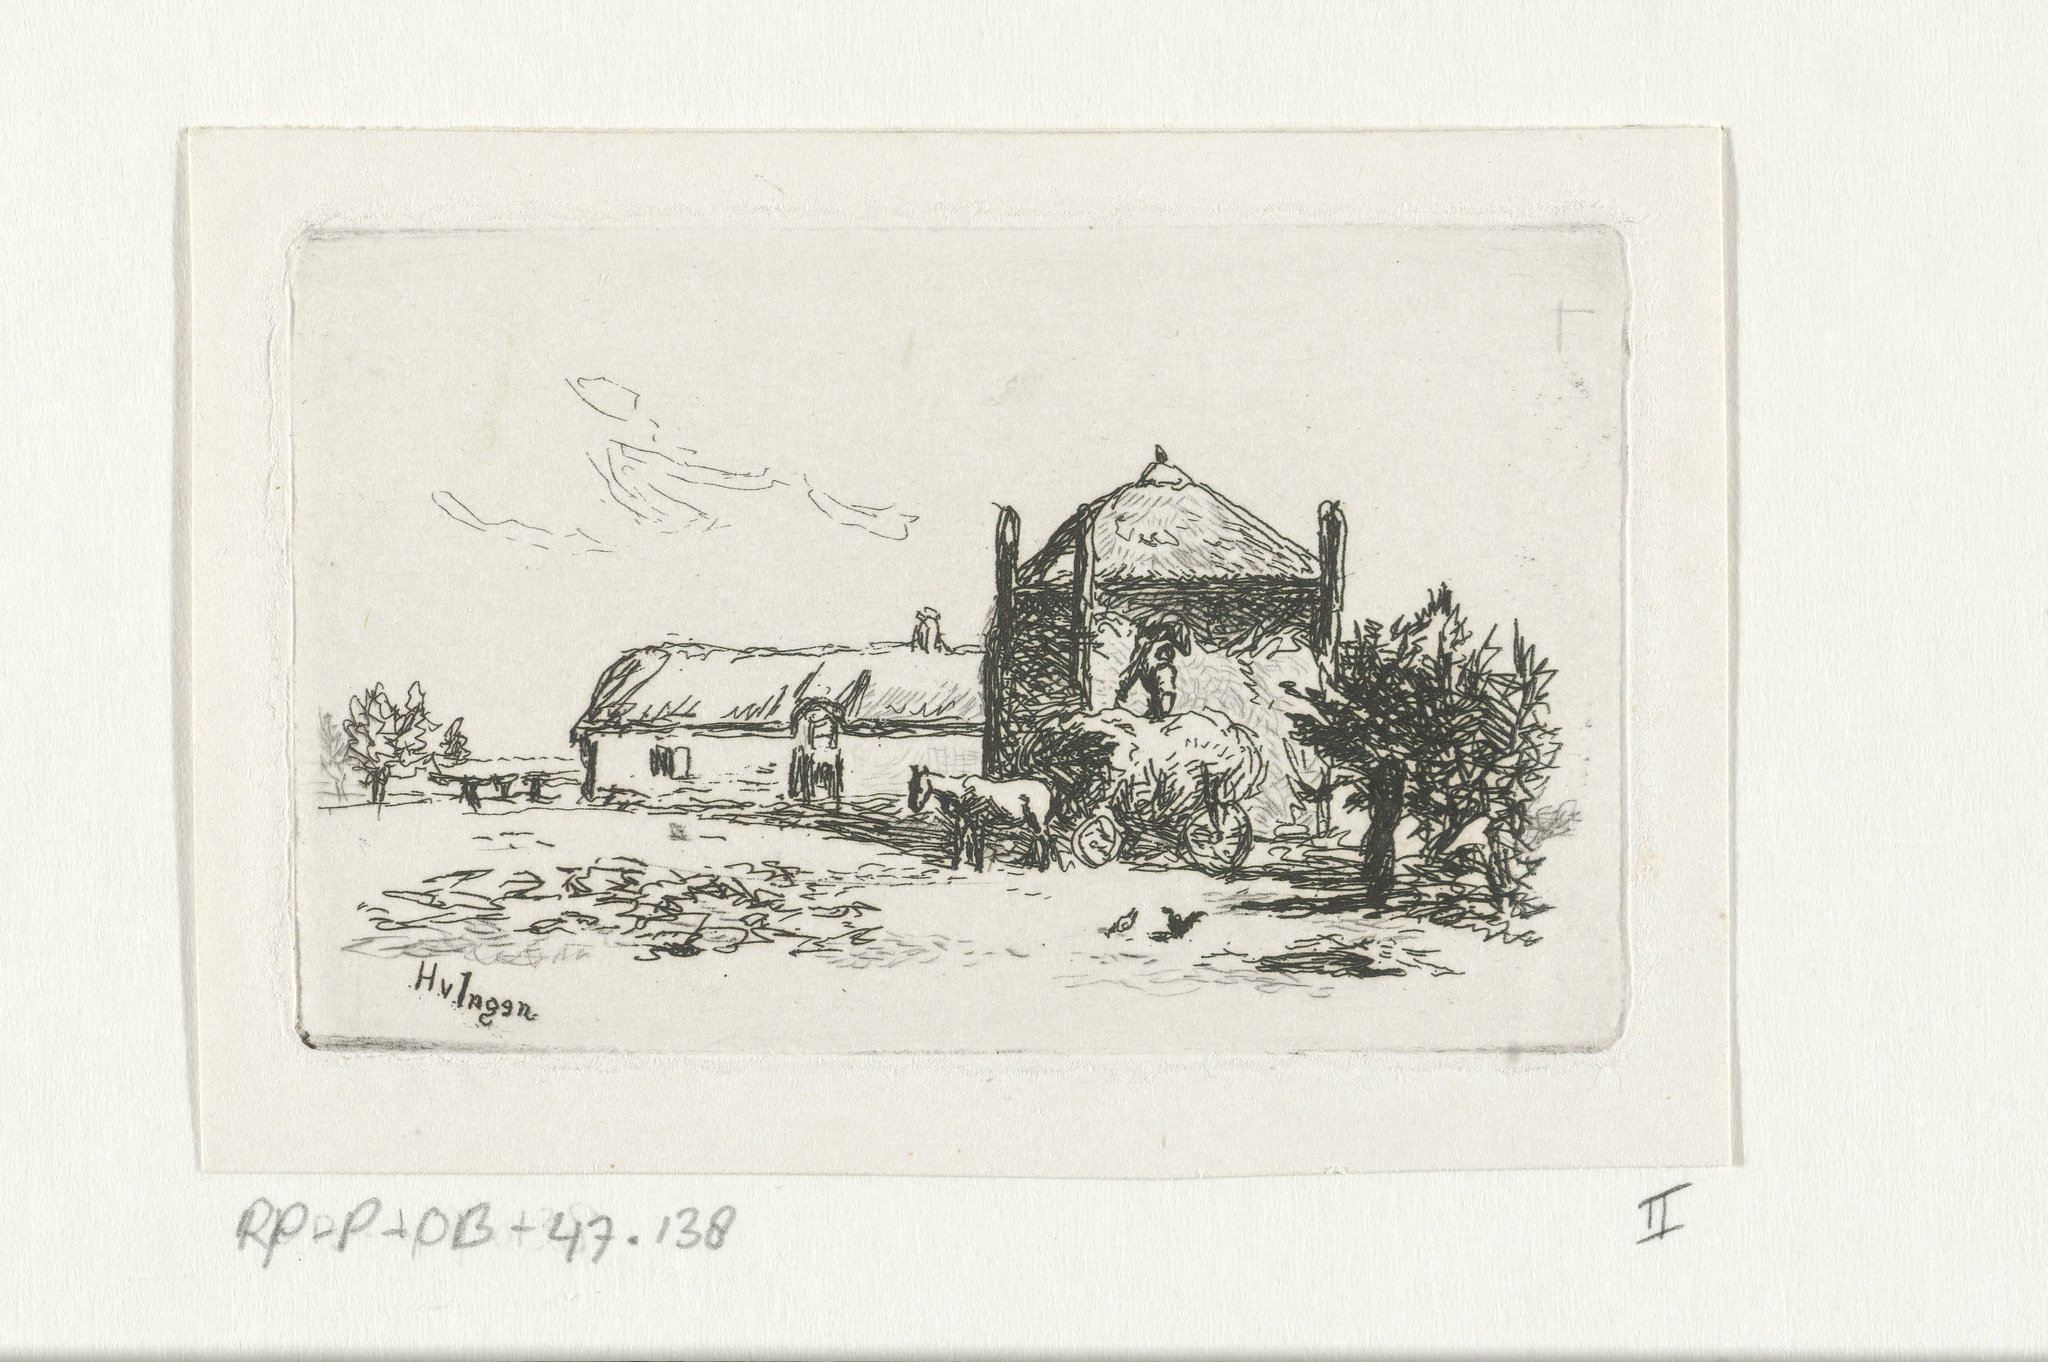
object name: print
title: Boerderij met hooiberg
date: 1844-1898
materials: paper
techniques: etching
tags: hay-stack, farm or solitary house in landscape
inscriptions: collector's mark: Lugt 2228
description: Een boerderij met hooiberg. Voor de hooiberg staan een paard en wagen met hooi. Op de wagen staat een man, die het hooi optast.